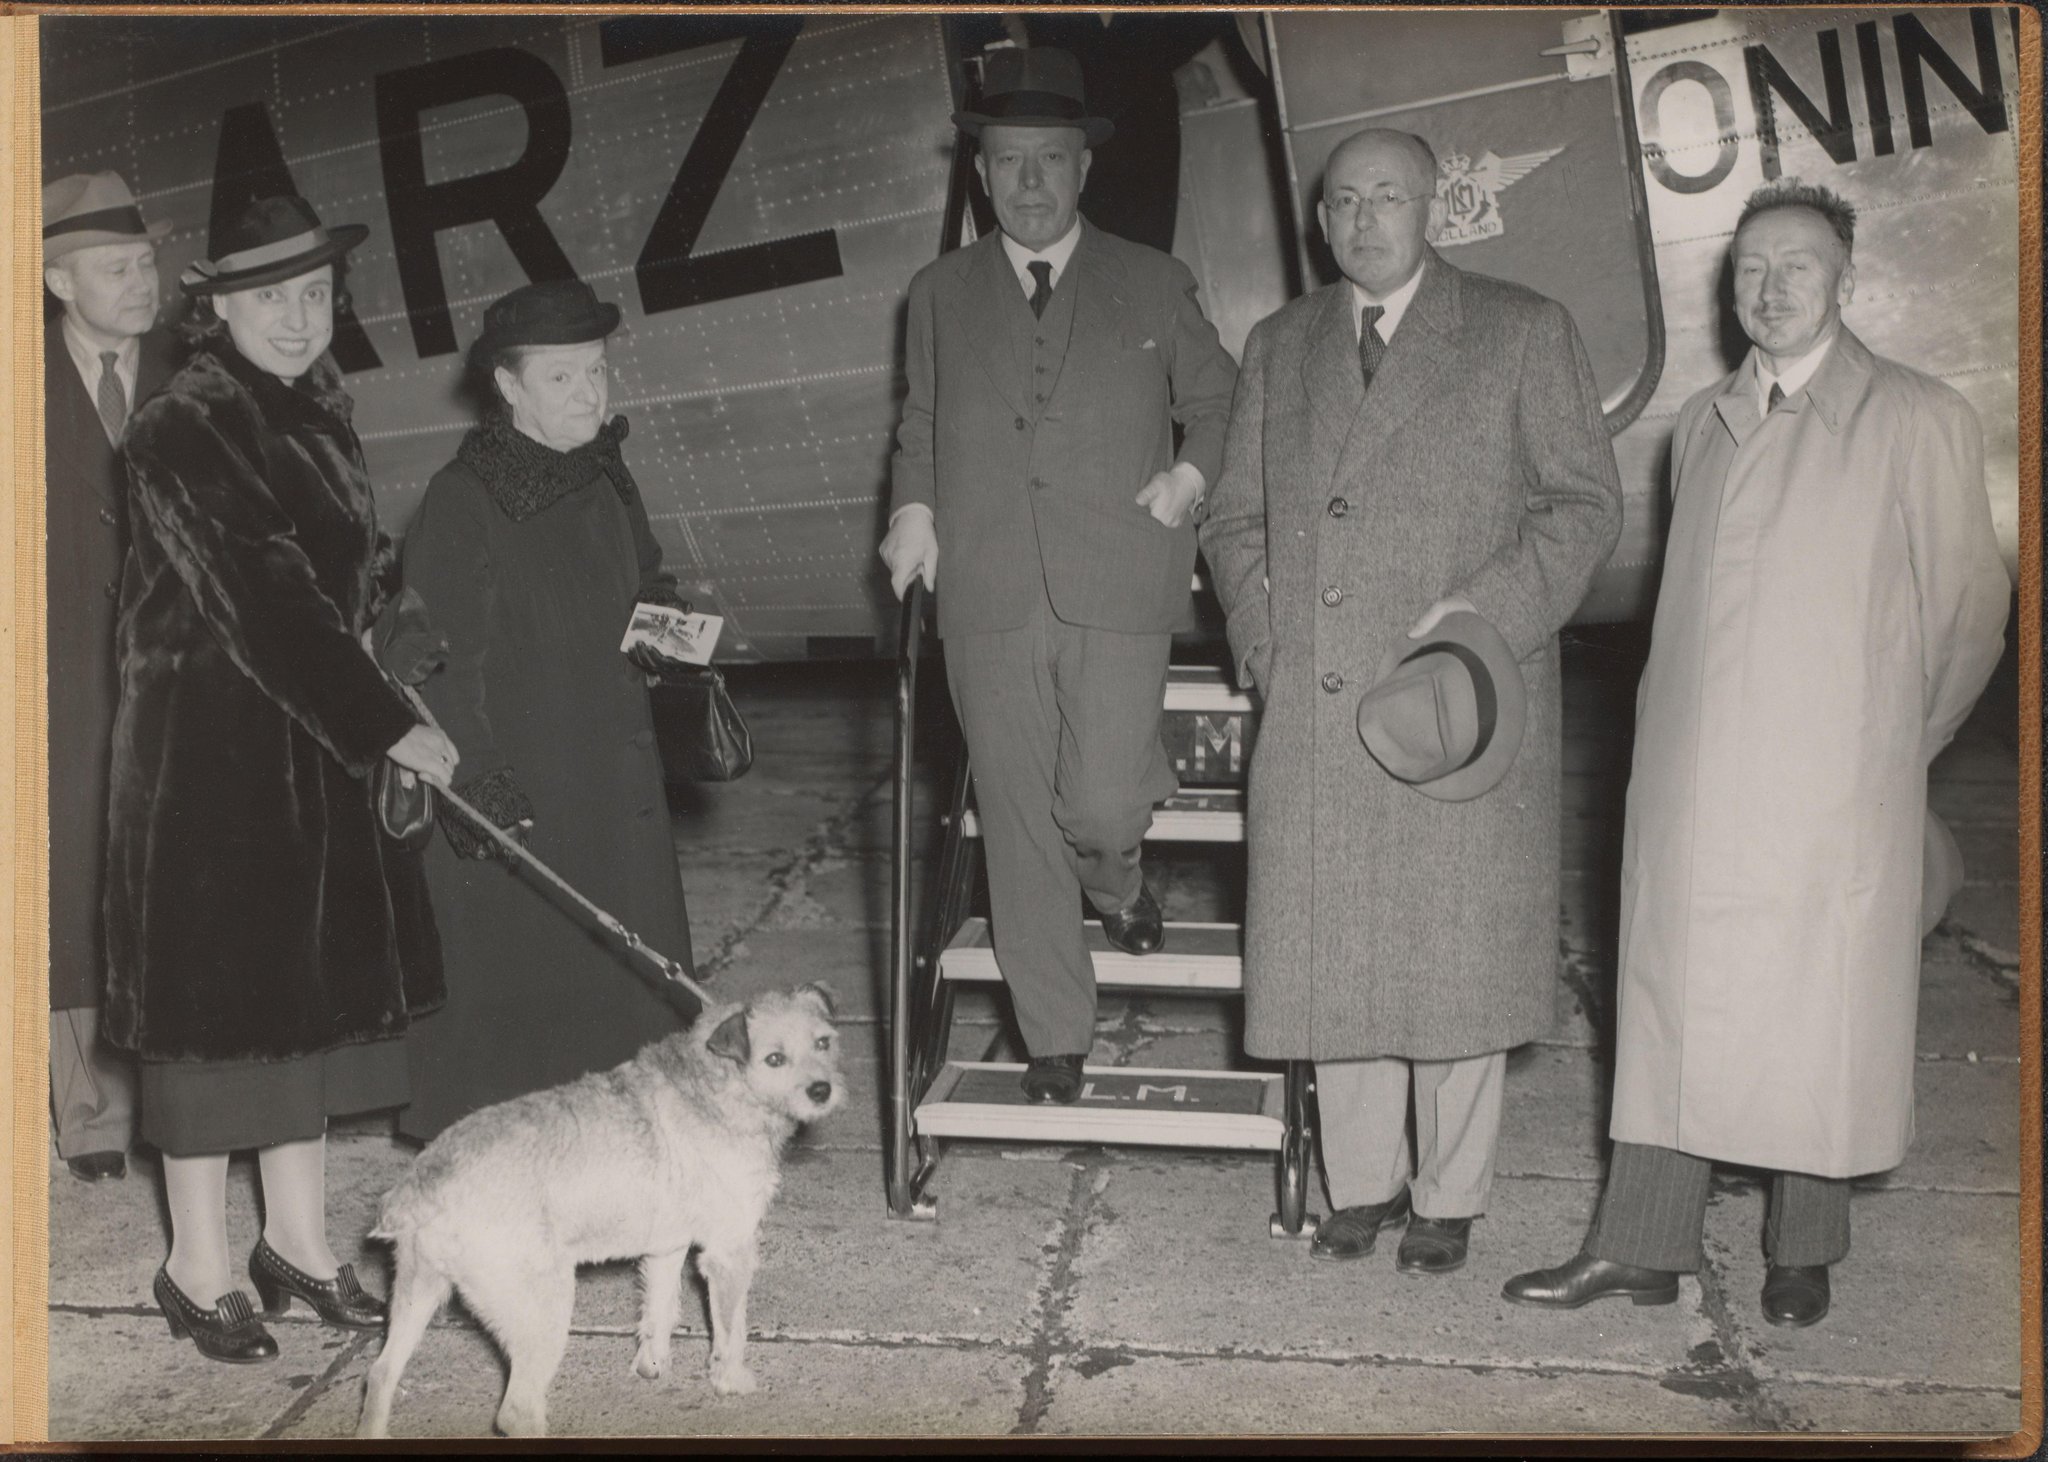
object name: photograph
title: Mannen en vrouwen onderaan een vliegtuigtrap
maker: Anonymous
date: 1930-1940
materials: cardboard, paper, photographic support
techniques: gelatin silver print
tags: leiden, the hague, airborne traffic, aviation, arrival and return ~ travelling, travelling; tourism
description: Albumblad met een foto van mannen en vrouwen onderaan een vliegtuigtrap. Tweede van rechts Hans Martin, de grondlegger van de Indië-lijn van de KLM. Onderdeel van Herdenkingsalbum van de Indië-lijn van de KLM, deel II.